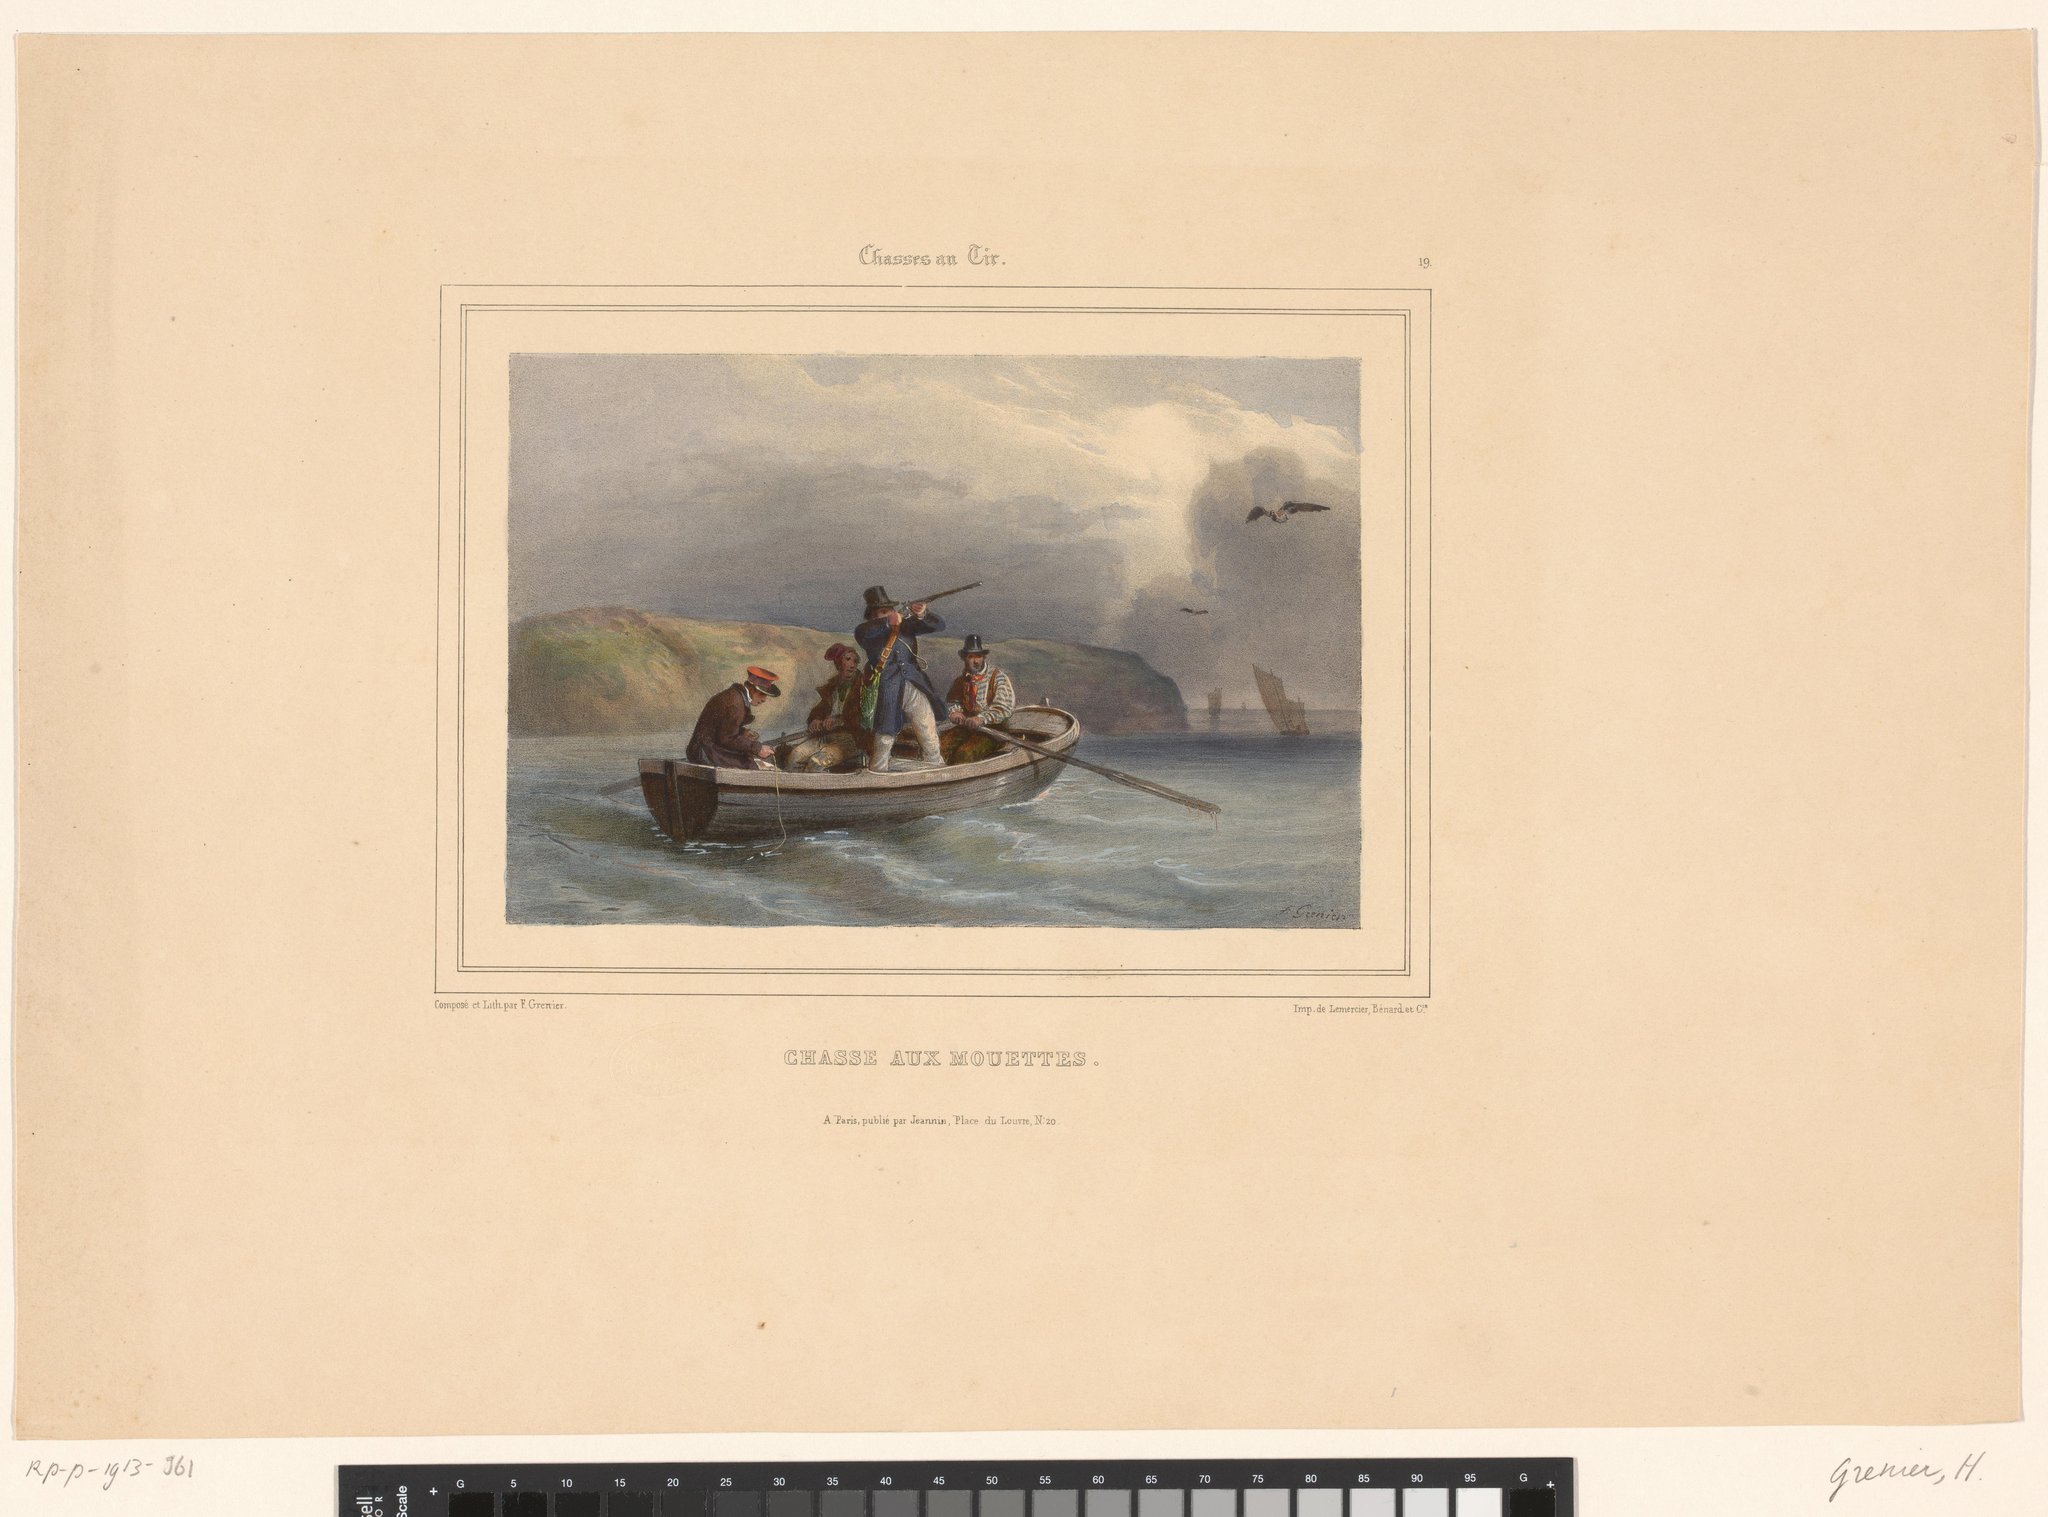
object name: print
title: Chasse aux mouettes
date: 1831-1846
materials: paper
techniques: hand coloring, lithograph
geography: paris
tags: hunter, bird hunting, shore-birds and wading-birds: gull, rowing-boat, canoe, etc., firearms: rifle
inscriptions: collector's mark: Lugt 2228a, check stamp: Lugt 1397c